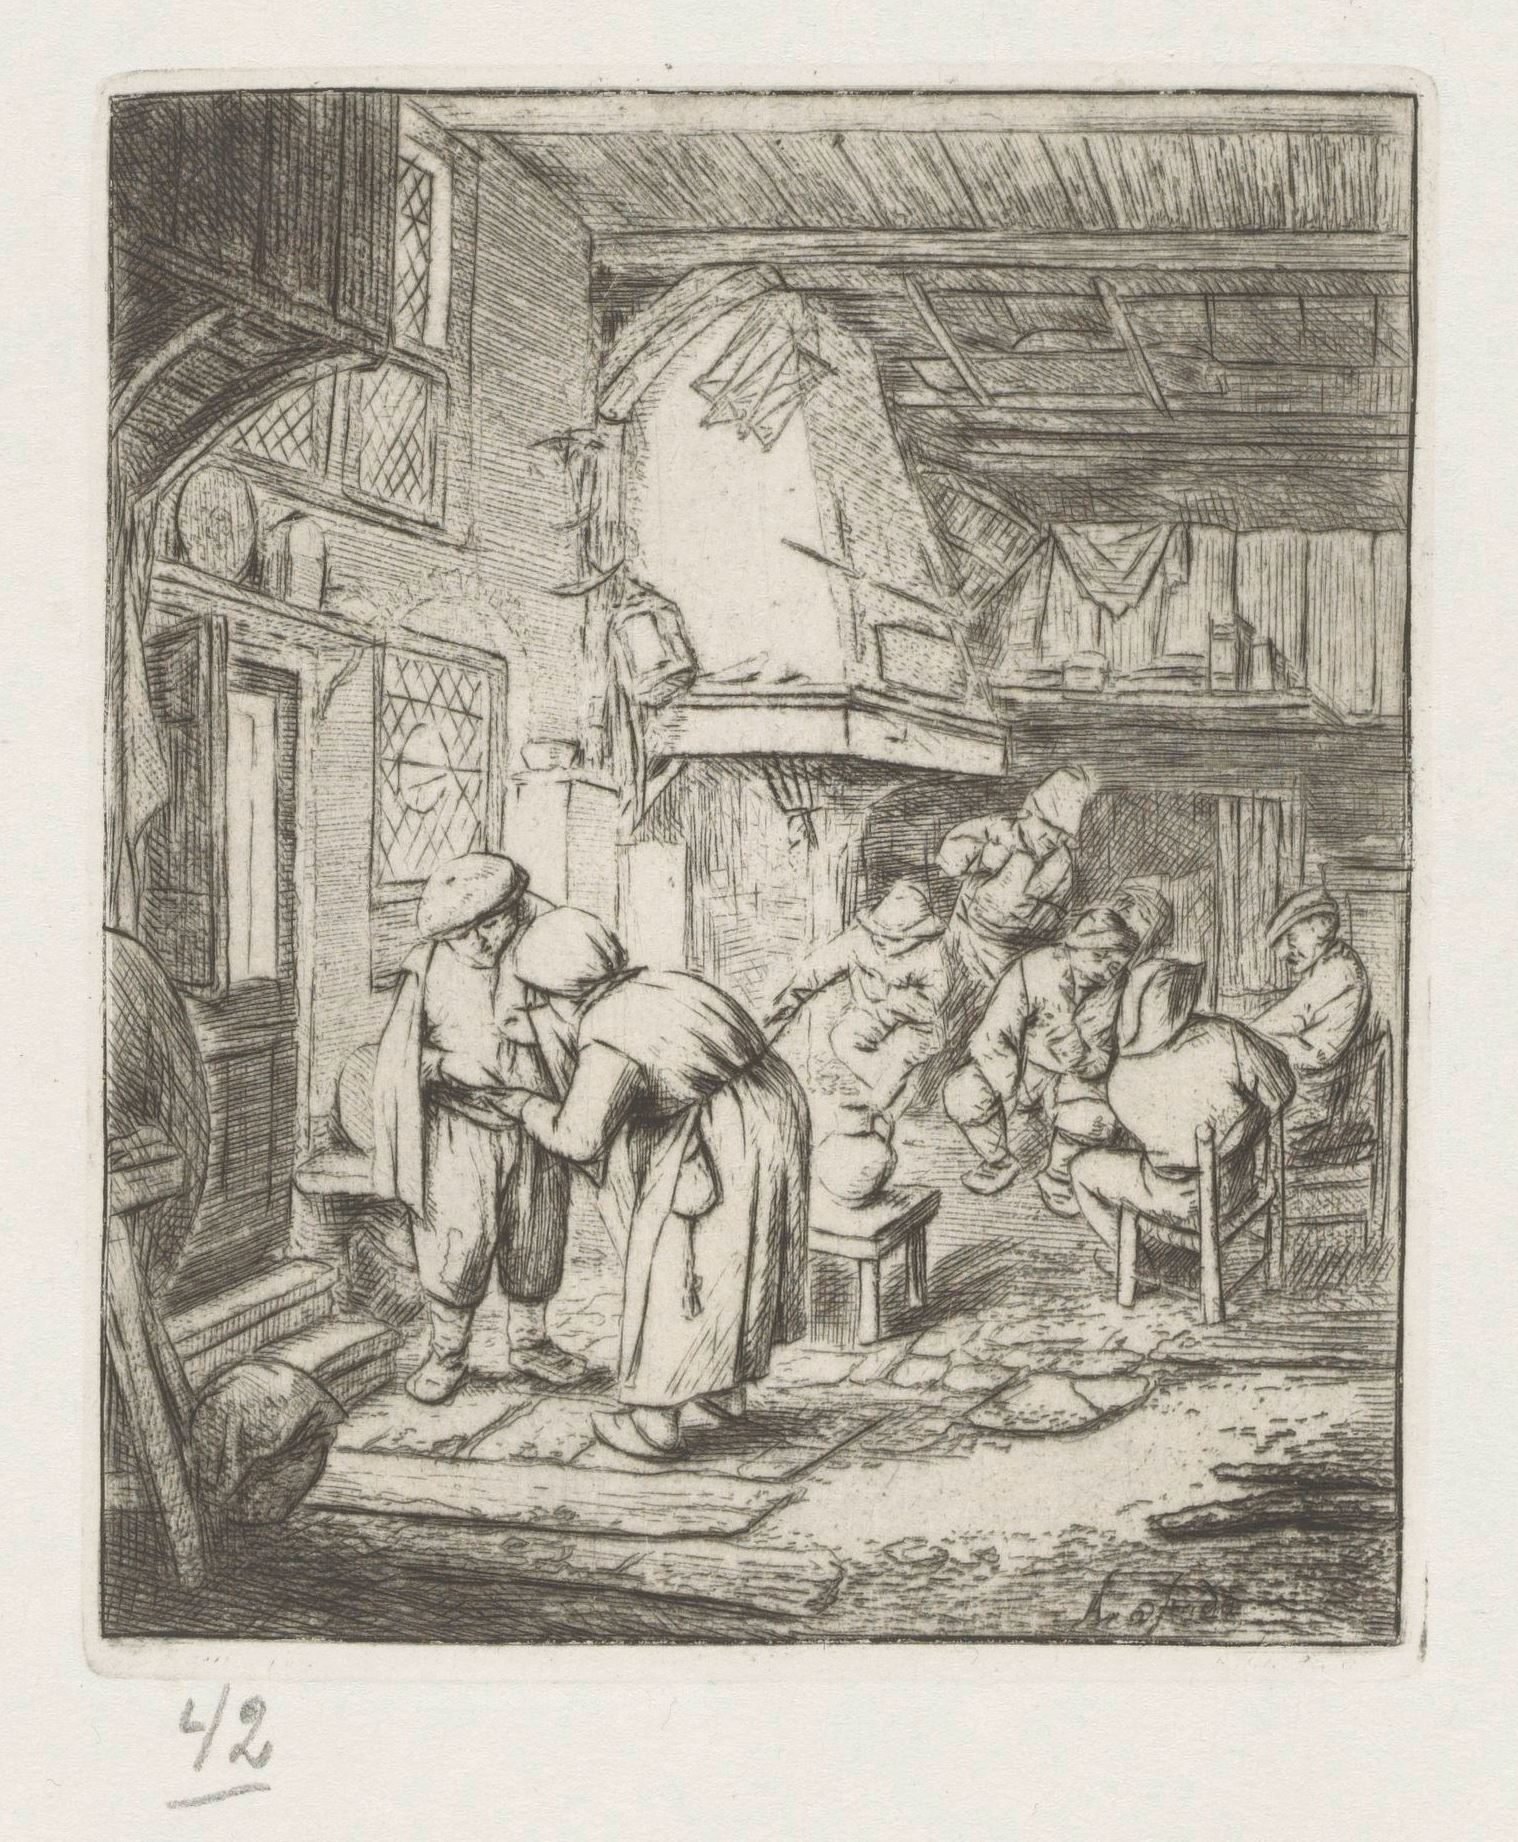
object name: print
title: Man betaalt zijn kosten aan vrouw in een herberg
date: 1647-1653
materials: paper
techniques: etching, galvanization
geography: haarlem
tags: inn, coffee-house, public house, etc., indoor recreation (+ paying, settling the bill ~ indoor recreation)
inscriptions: collector's mark: ‘RIJKS / MUSM’, collector's mark: ‘B’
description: Interieur van een herberg met een boer die zijn gemaakte kosten afrekent met een vrouw. Door de ramen en een half geopende deur valt licht naar binnen ook op een groep mannen bij de haard achter in het vertrek. De prent maakt deel uit van een portefeuille en is met een andere prent op één albumblad gedrukt.